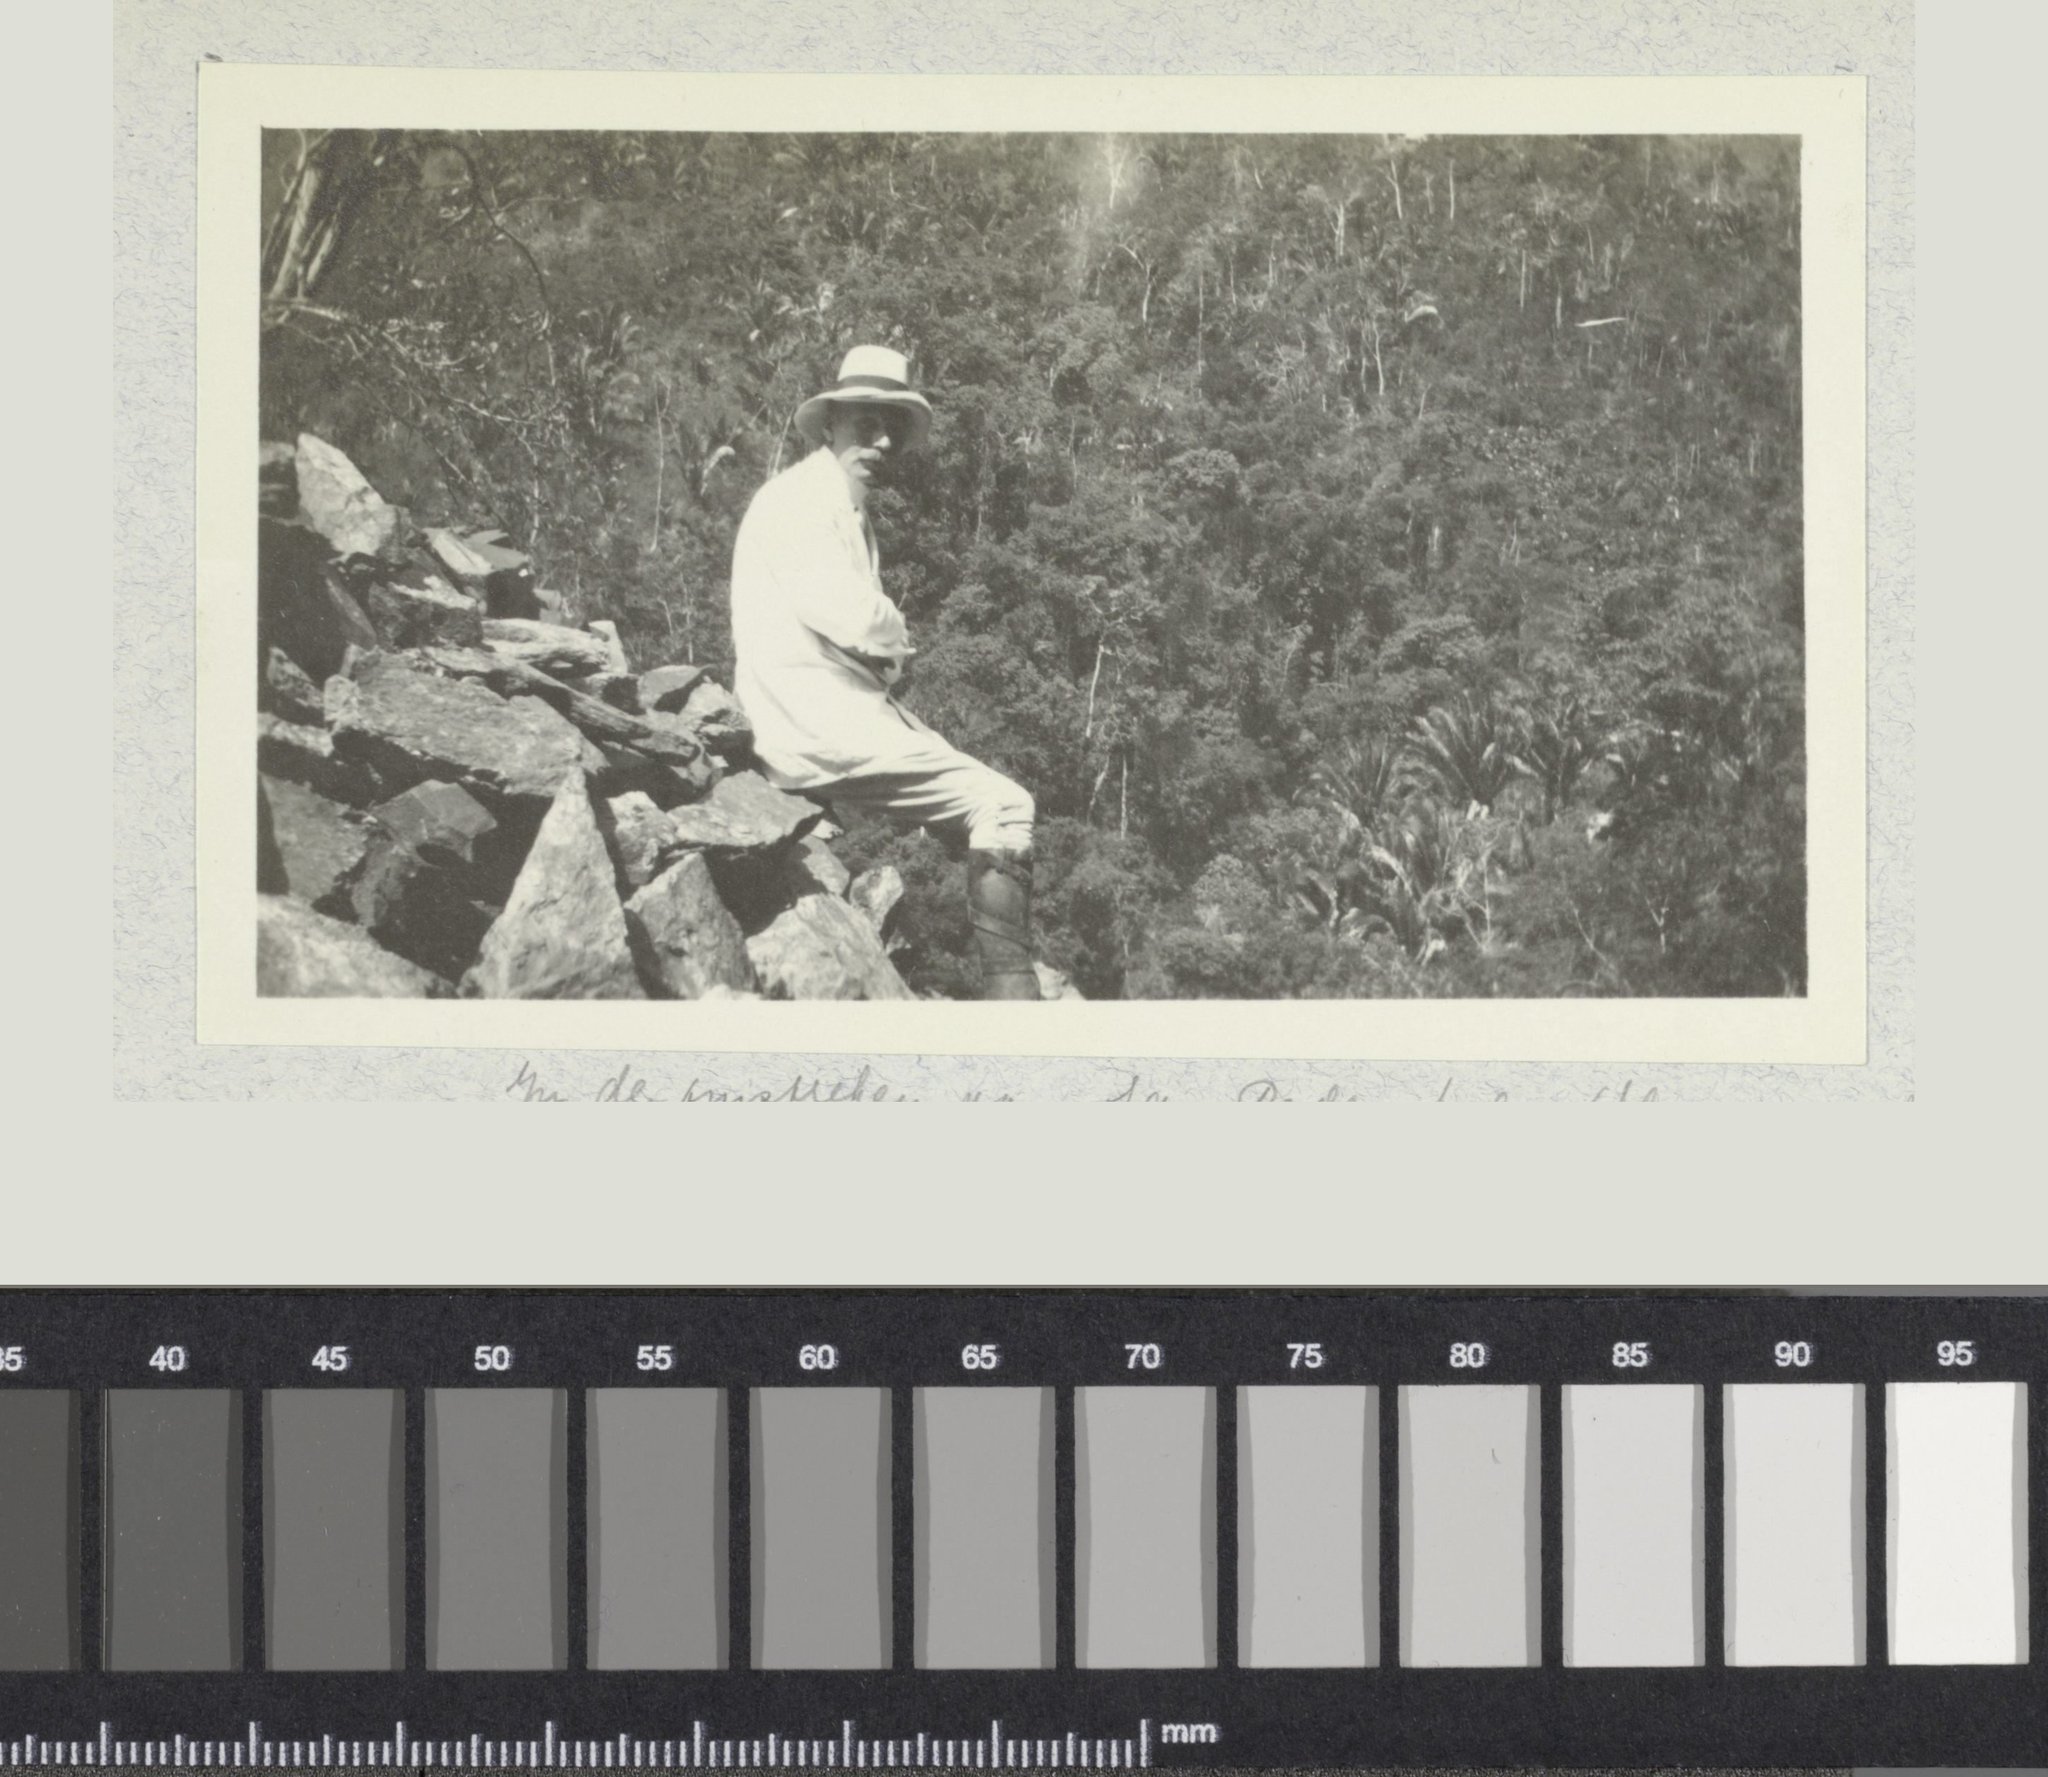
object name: photograph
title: In de bergen van Honduras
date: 1908-1912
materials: photographic support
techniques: photography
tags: amsterdam, andries augustus boom, landscapes in tropical and sub-tropical regions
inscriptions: inscription: ‘In de kuststreken van San Pedro Sula (Honduras) / Aug. '12.’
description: Andries Boom op een berghelling bij San Pedro Sula in Honduras, augustus 1912. Onderdeel van het fotoalbum van de familie Boom-Gonggrijp in Suriname en Curaçao.